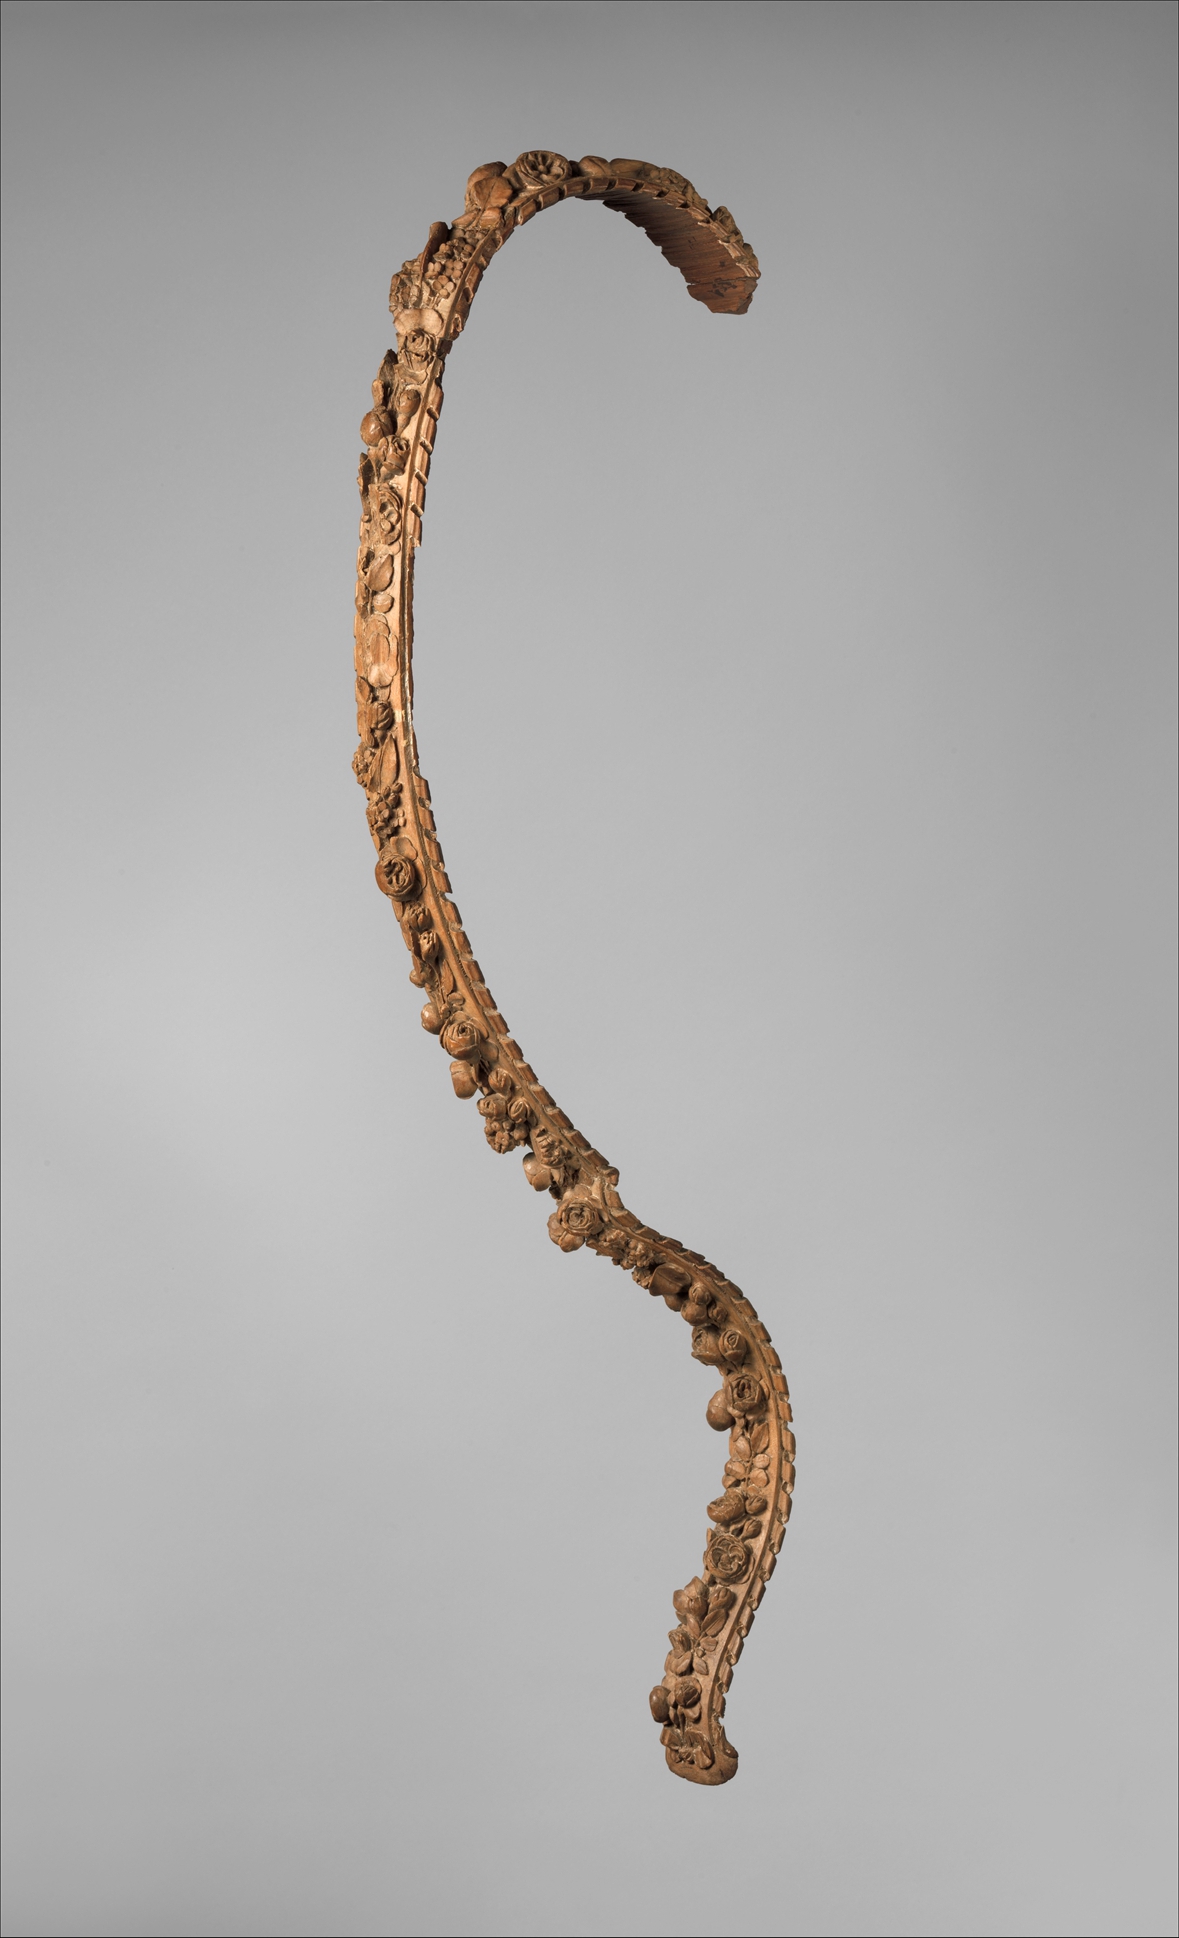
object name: chair arm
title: Chair arm (?)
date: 1701-1800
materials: wood